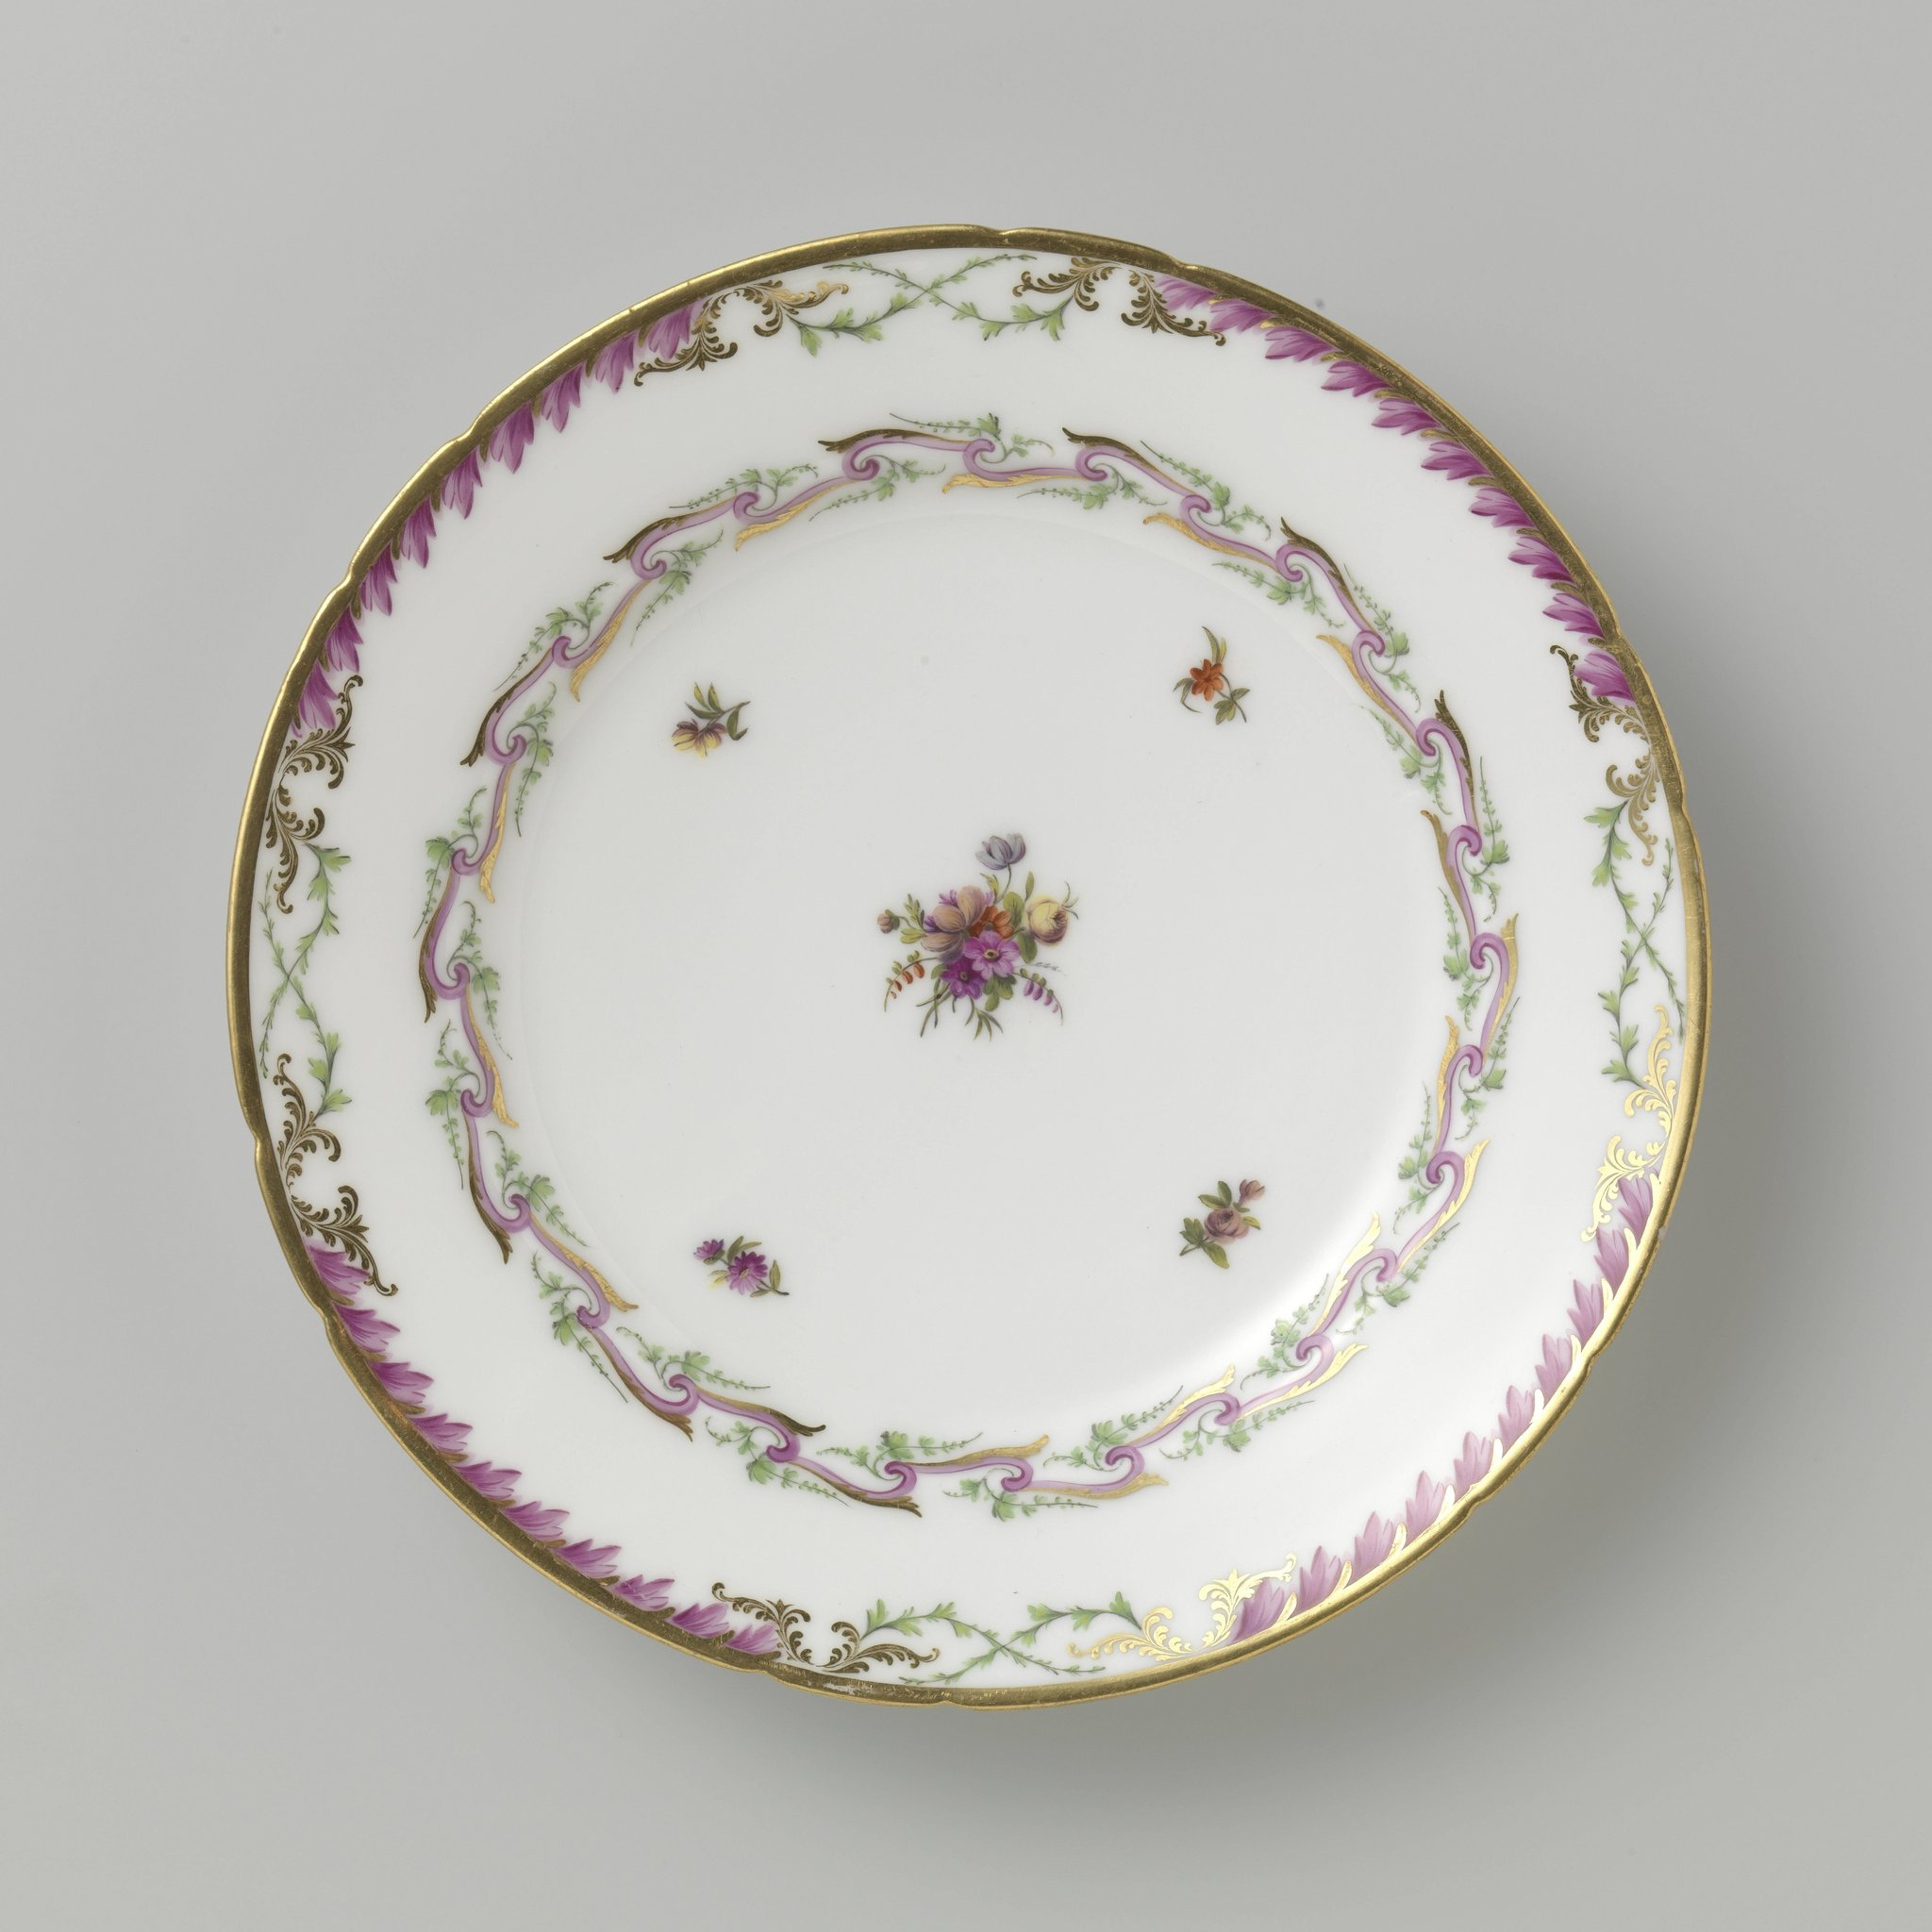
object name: plate dish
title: Bord, plat model, behorend bij een servies met geslingerd lintmotief met bladertakken, bloemboeketten en gestrooide bloemtakken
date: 1780-1820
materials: porcelain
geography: amsterdam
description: Bord, plat model, behorend bij een servies van porselein met geslingerd lintmotief in paars en goud met groene bladertakken, bloemboeketten en gestrooide bloemtakken. Randen lichtgegolfd met decoratie in goud met paars bladmotief waartussen groen gekruist bladmotief. Gemerkt: M.O.L. en AMSTEL. Serie van zevenendertig stuks (17 met merk M.O.L.; 18 met merk Amstel).